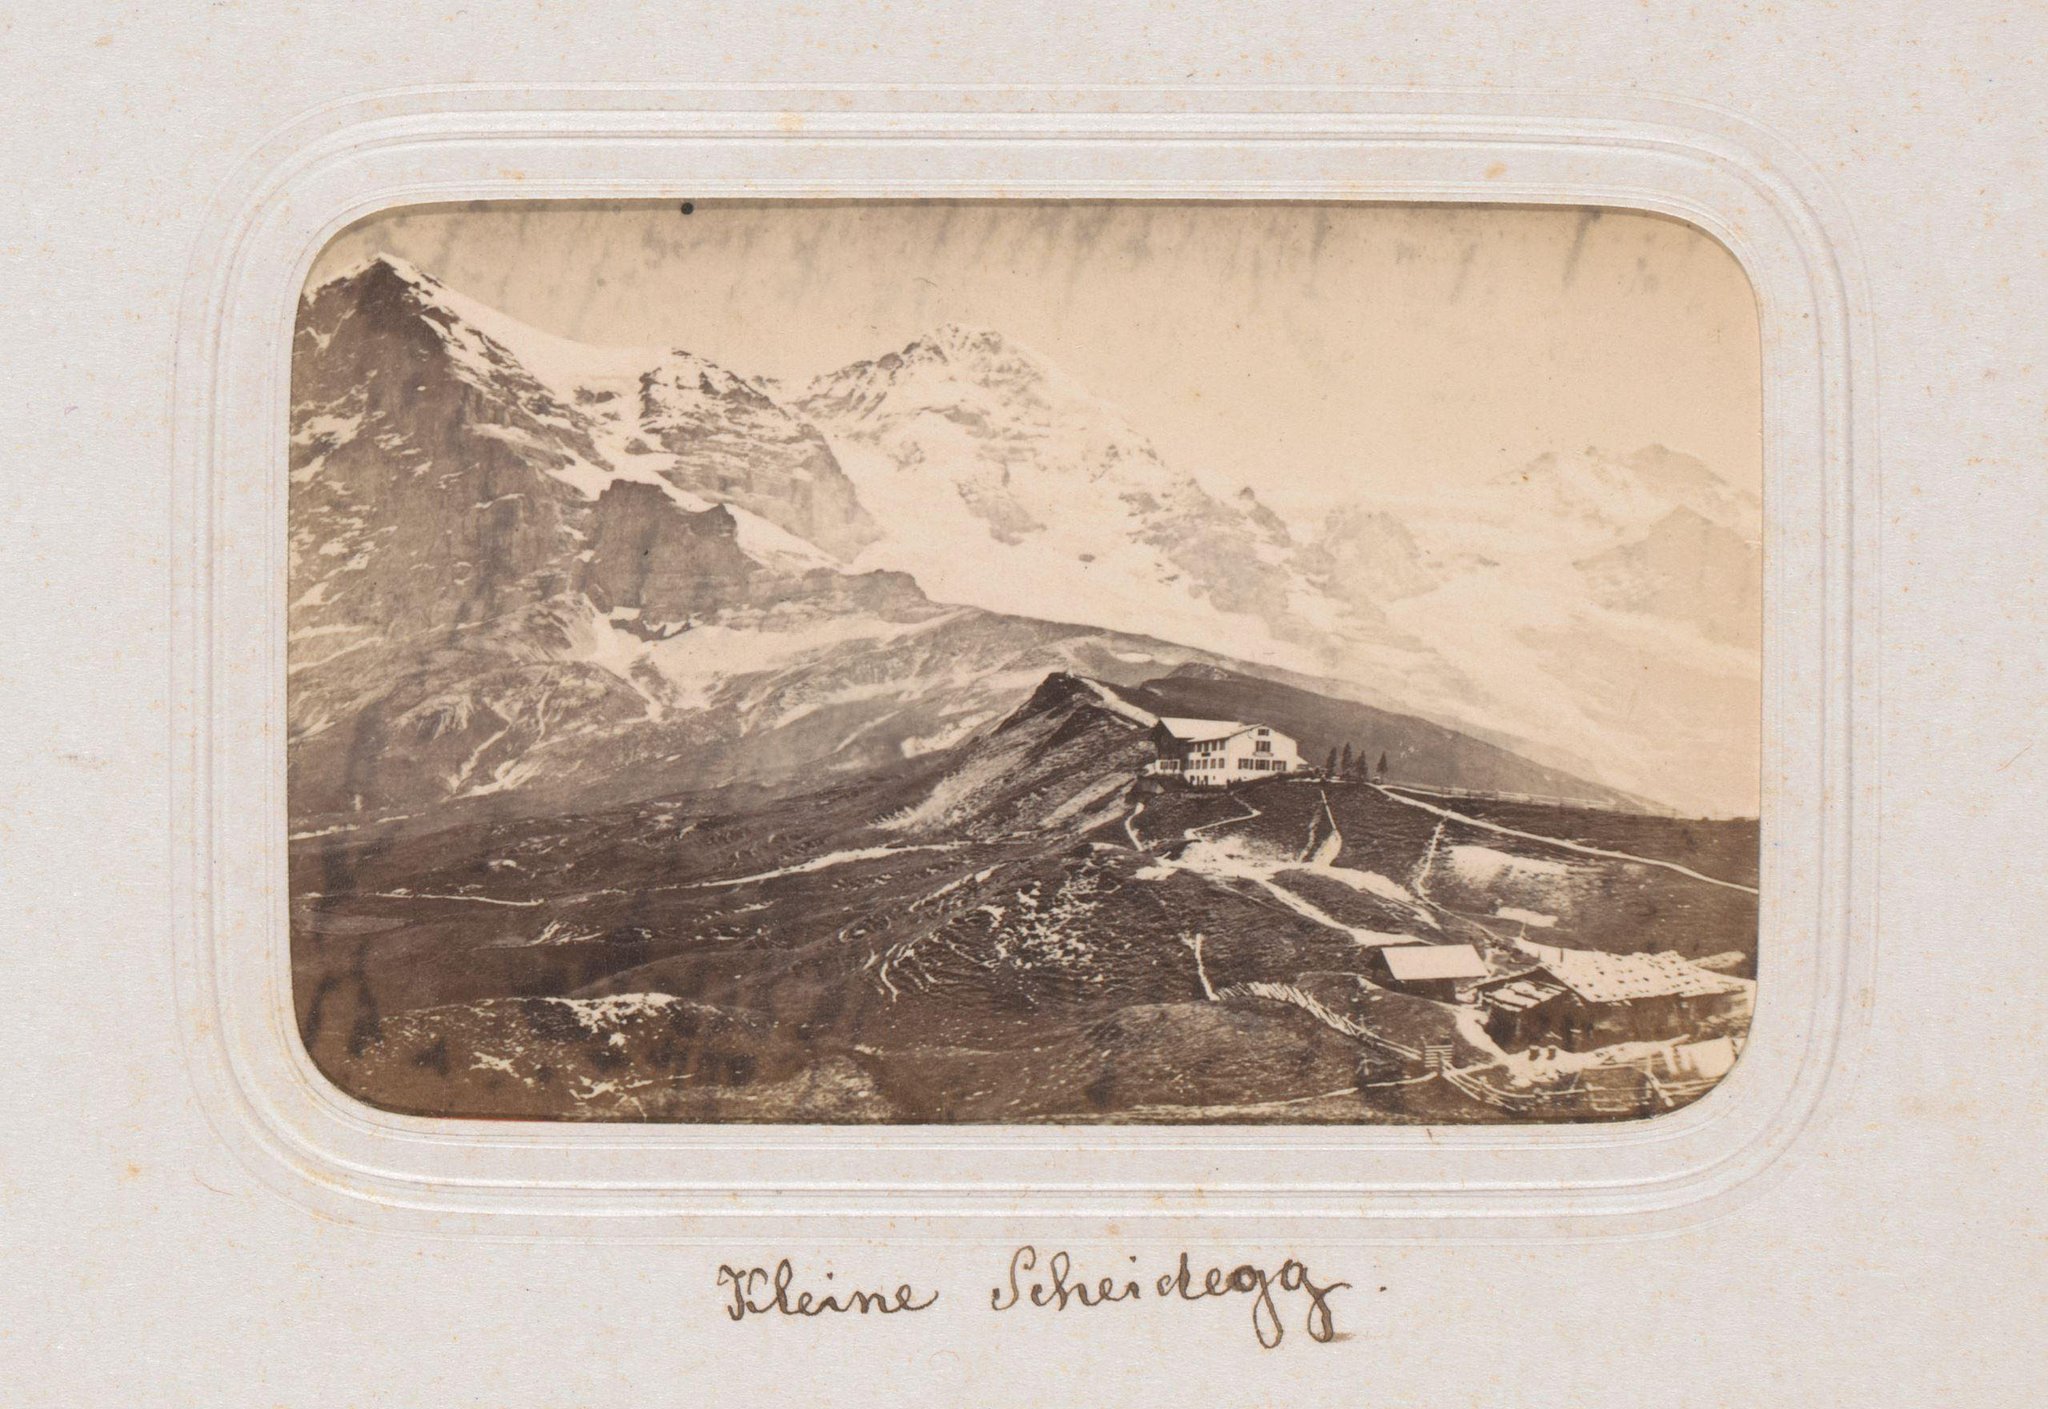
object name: album leaf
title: La Jungfrau le Munch et l'Eiger vue prise de la Petite Scheideck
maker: florentin charnaux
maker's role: publisher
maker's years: 1819-1883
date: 1871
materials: cardboard, paper, photographic support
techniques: albumen print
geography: alps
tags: mountain-range, snow peaks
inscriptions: number: ‘216’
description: Onderdeel van Reisalbum met foto's van bezienswaardigheden in Zwitserland.